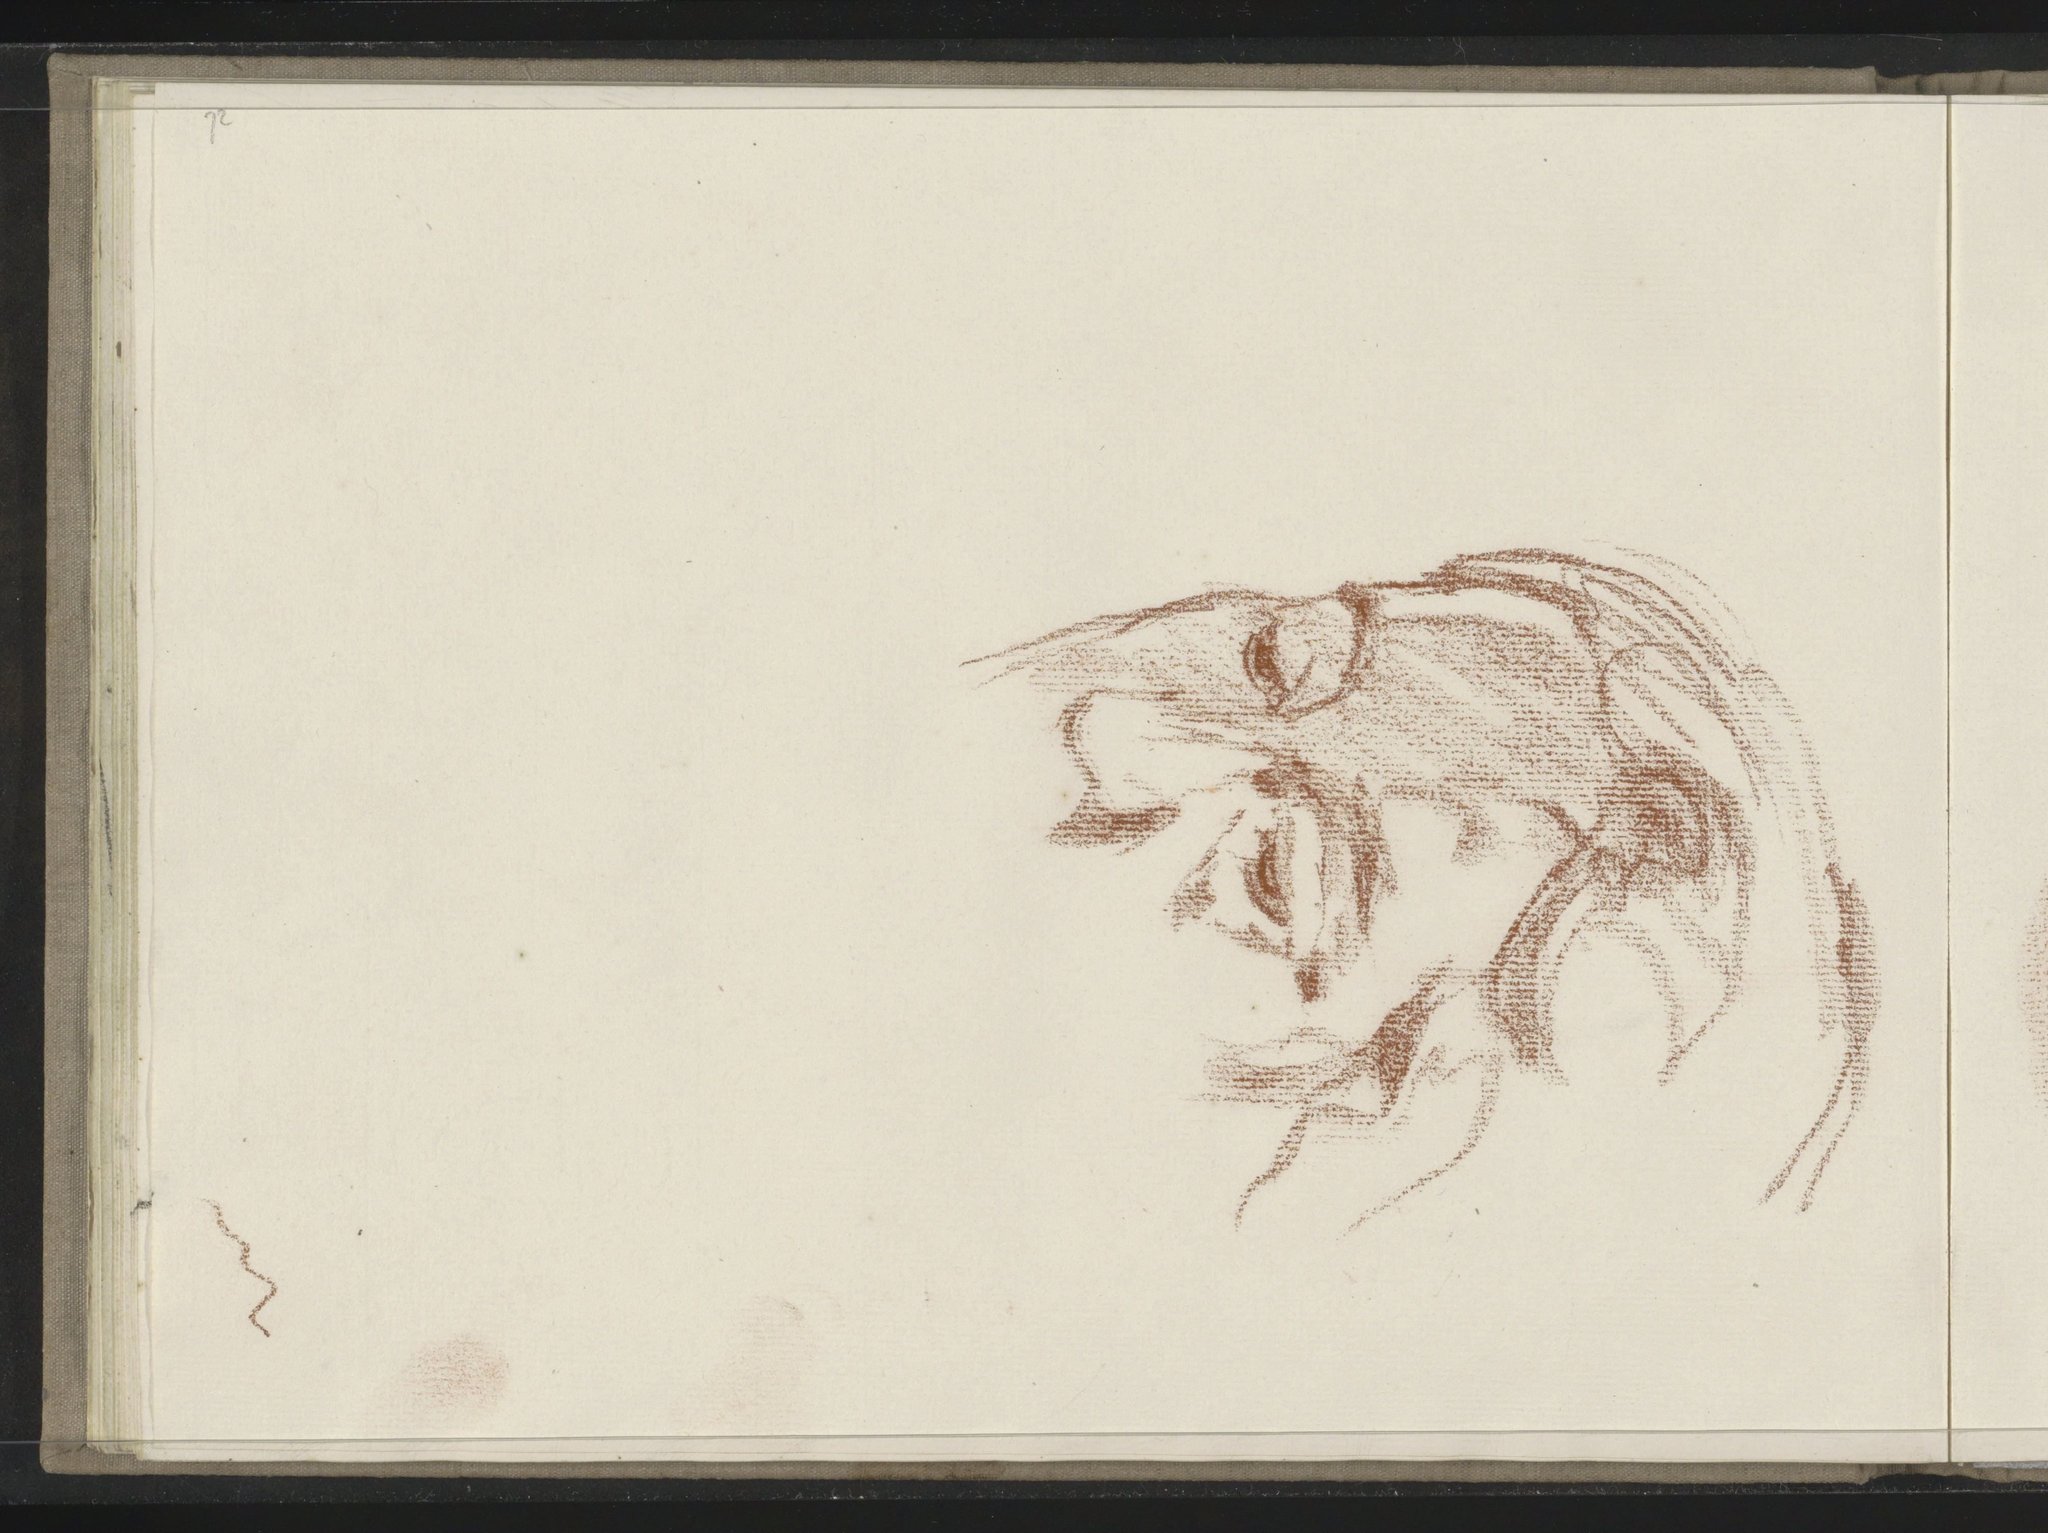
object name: sketchbook leaf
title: Vrouwenhoofd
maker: willem witsen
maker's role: draughtsman, painter, print maker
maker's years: 1860-1923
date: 1888-1907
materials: chalk, paper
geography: amsterdam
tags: head (human) - aa - female human figure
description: Pagina 72 uit een schetsboek met 72 bladen.